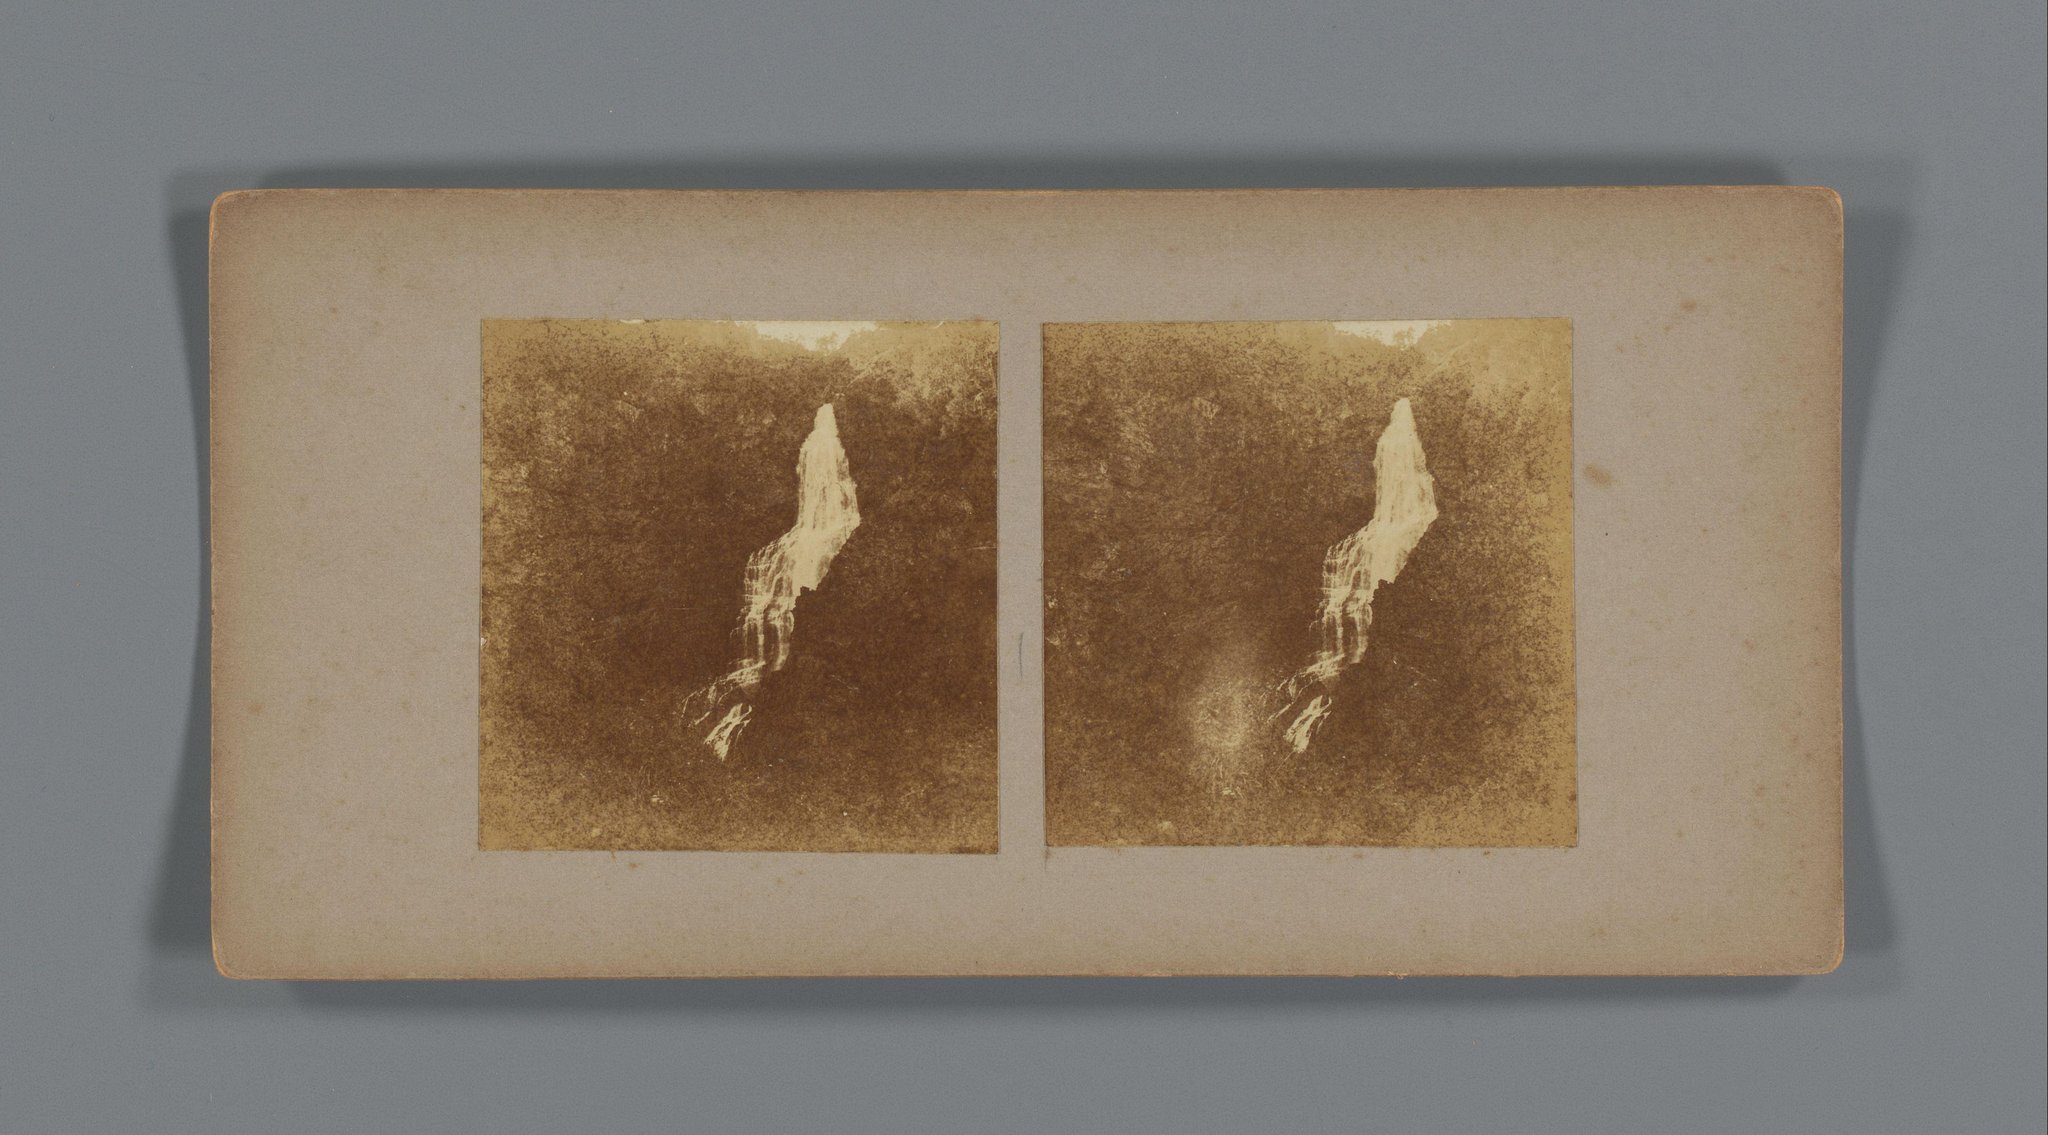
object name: stereograph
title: Sivlefos bij Stalheim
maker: Anonymous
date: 1882-1890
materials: cardboard, photographic support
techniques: gelatin silver print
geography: stalheim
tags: waterfall